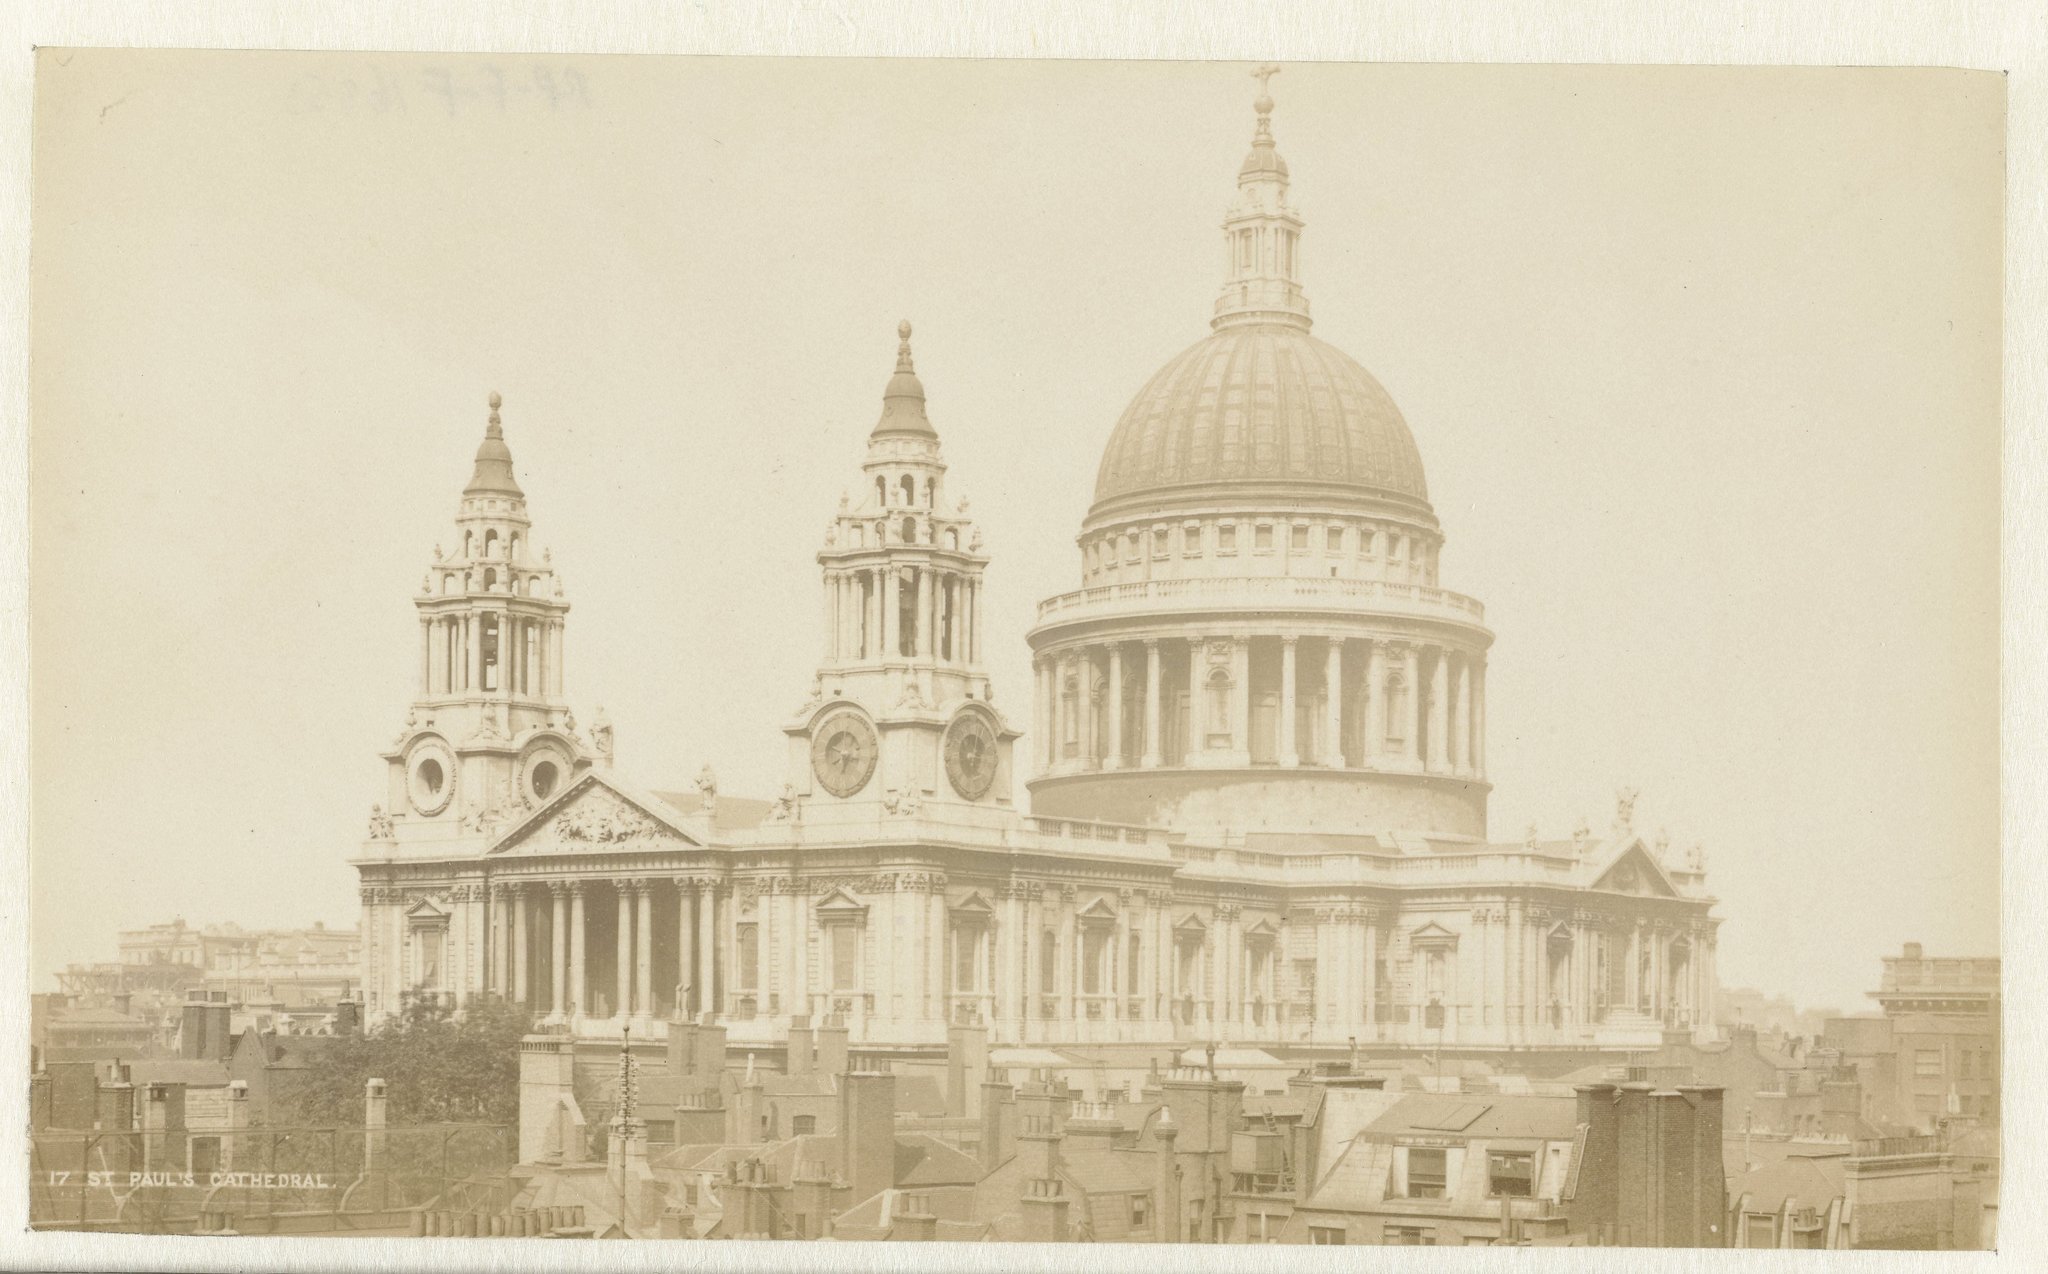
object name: photograph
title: Saint Paul's Cathedral in Londen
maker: Anonymous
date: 1851-1900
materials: paper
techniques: albumen print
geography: london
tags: church (exterior)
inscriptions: number: ‘17’